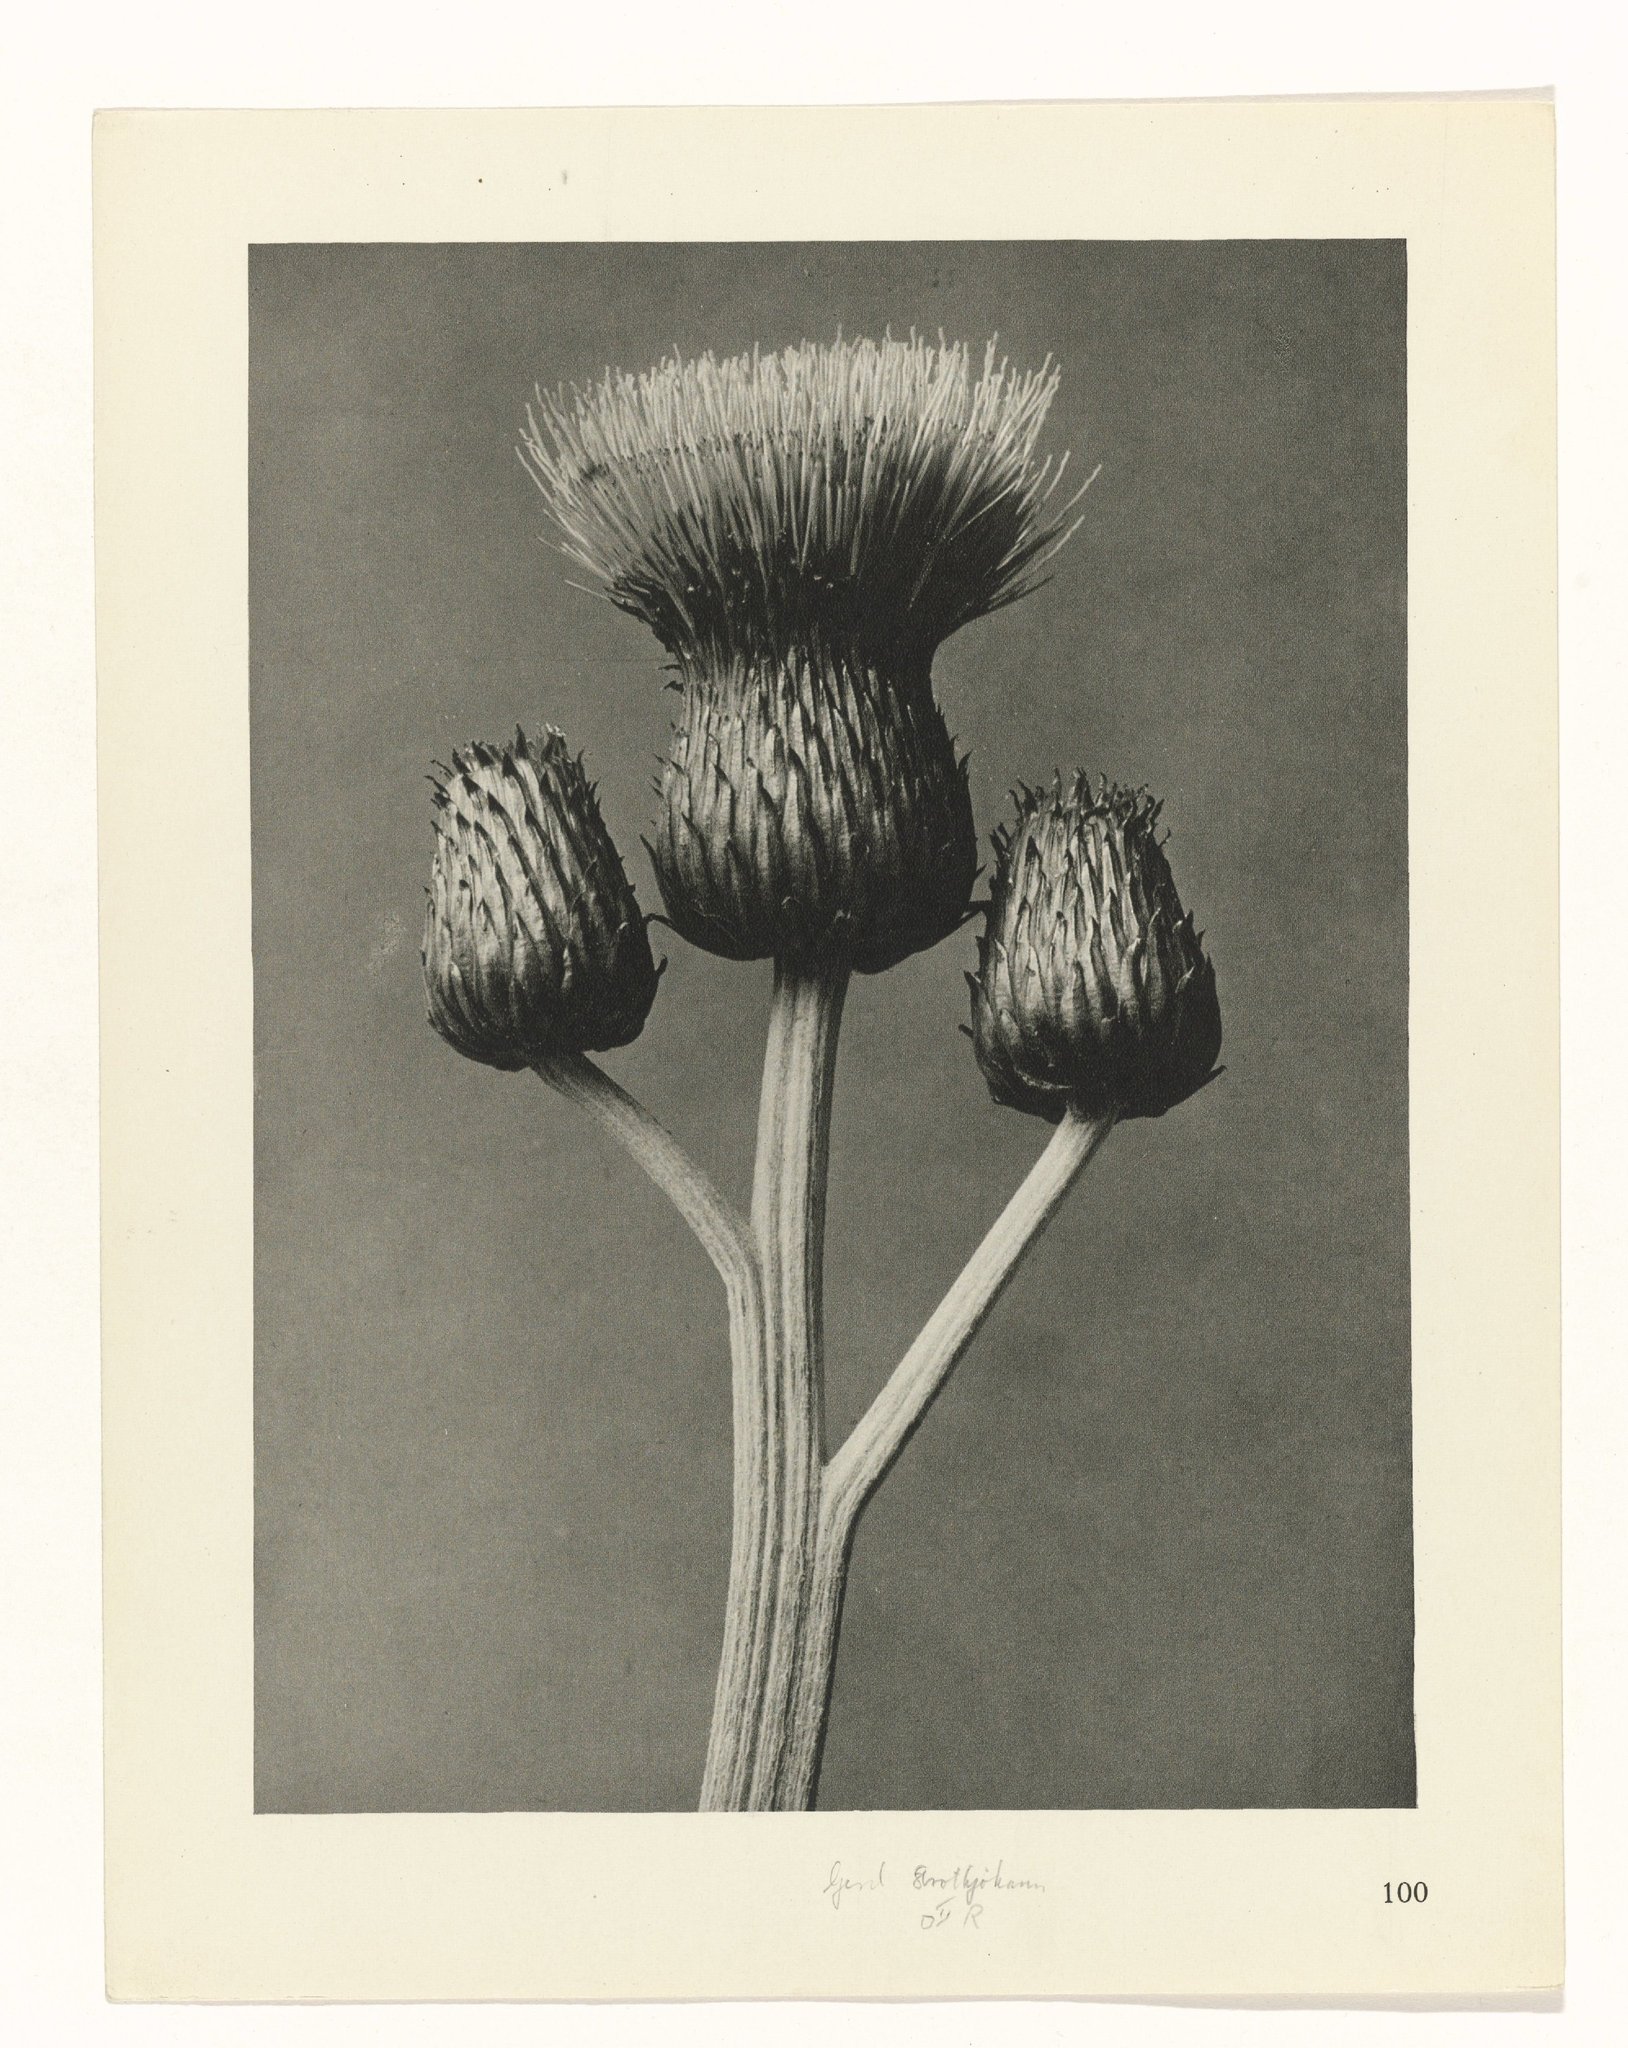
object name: photograph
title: Urformen der Kunst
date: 1928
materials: ink, paper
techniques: rotogravure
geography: berlin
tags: plants (in general)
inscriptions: number: ‘100’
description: facher Vergrößerung. Afkomstig uit losbladige uitgave.